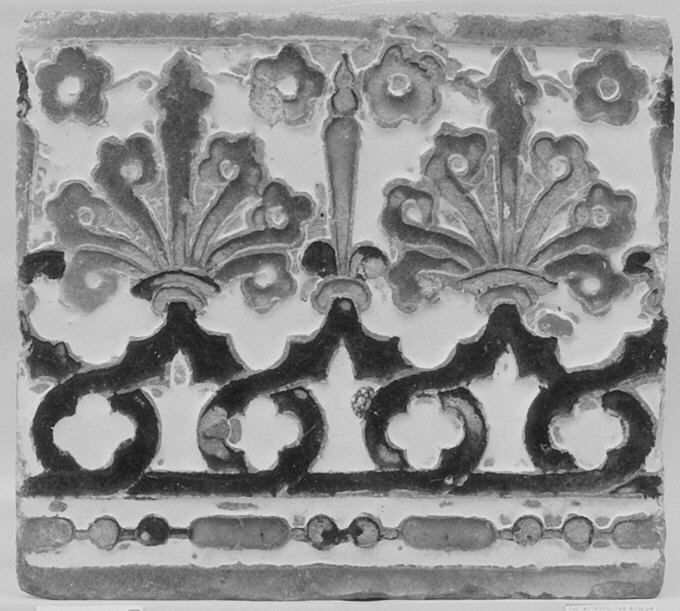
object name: tile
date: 1501-1600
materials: earthenware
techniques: glazing